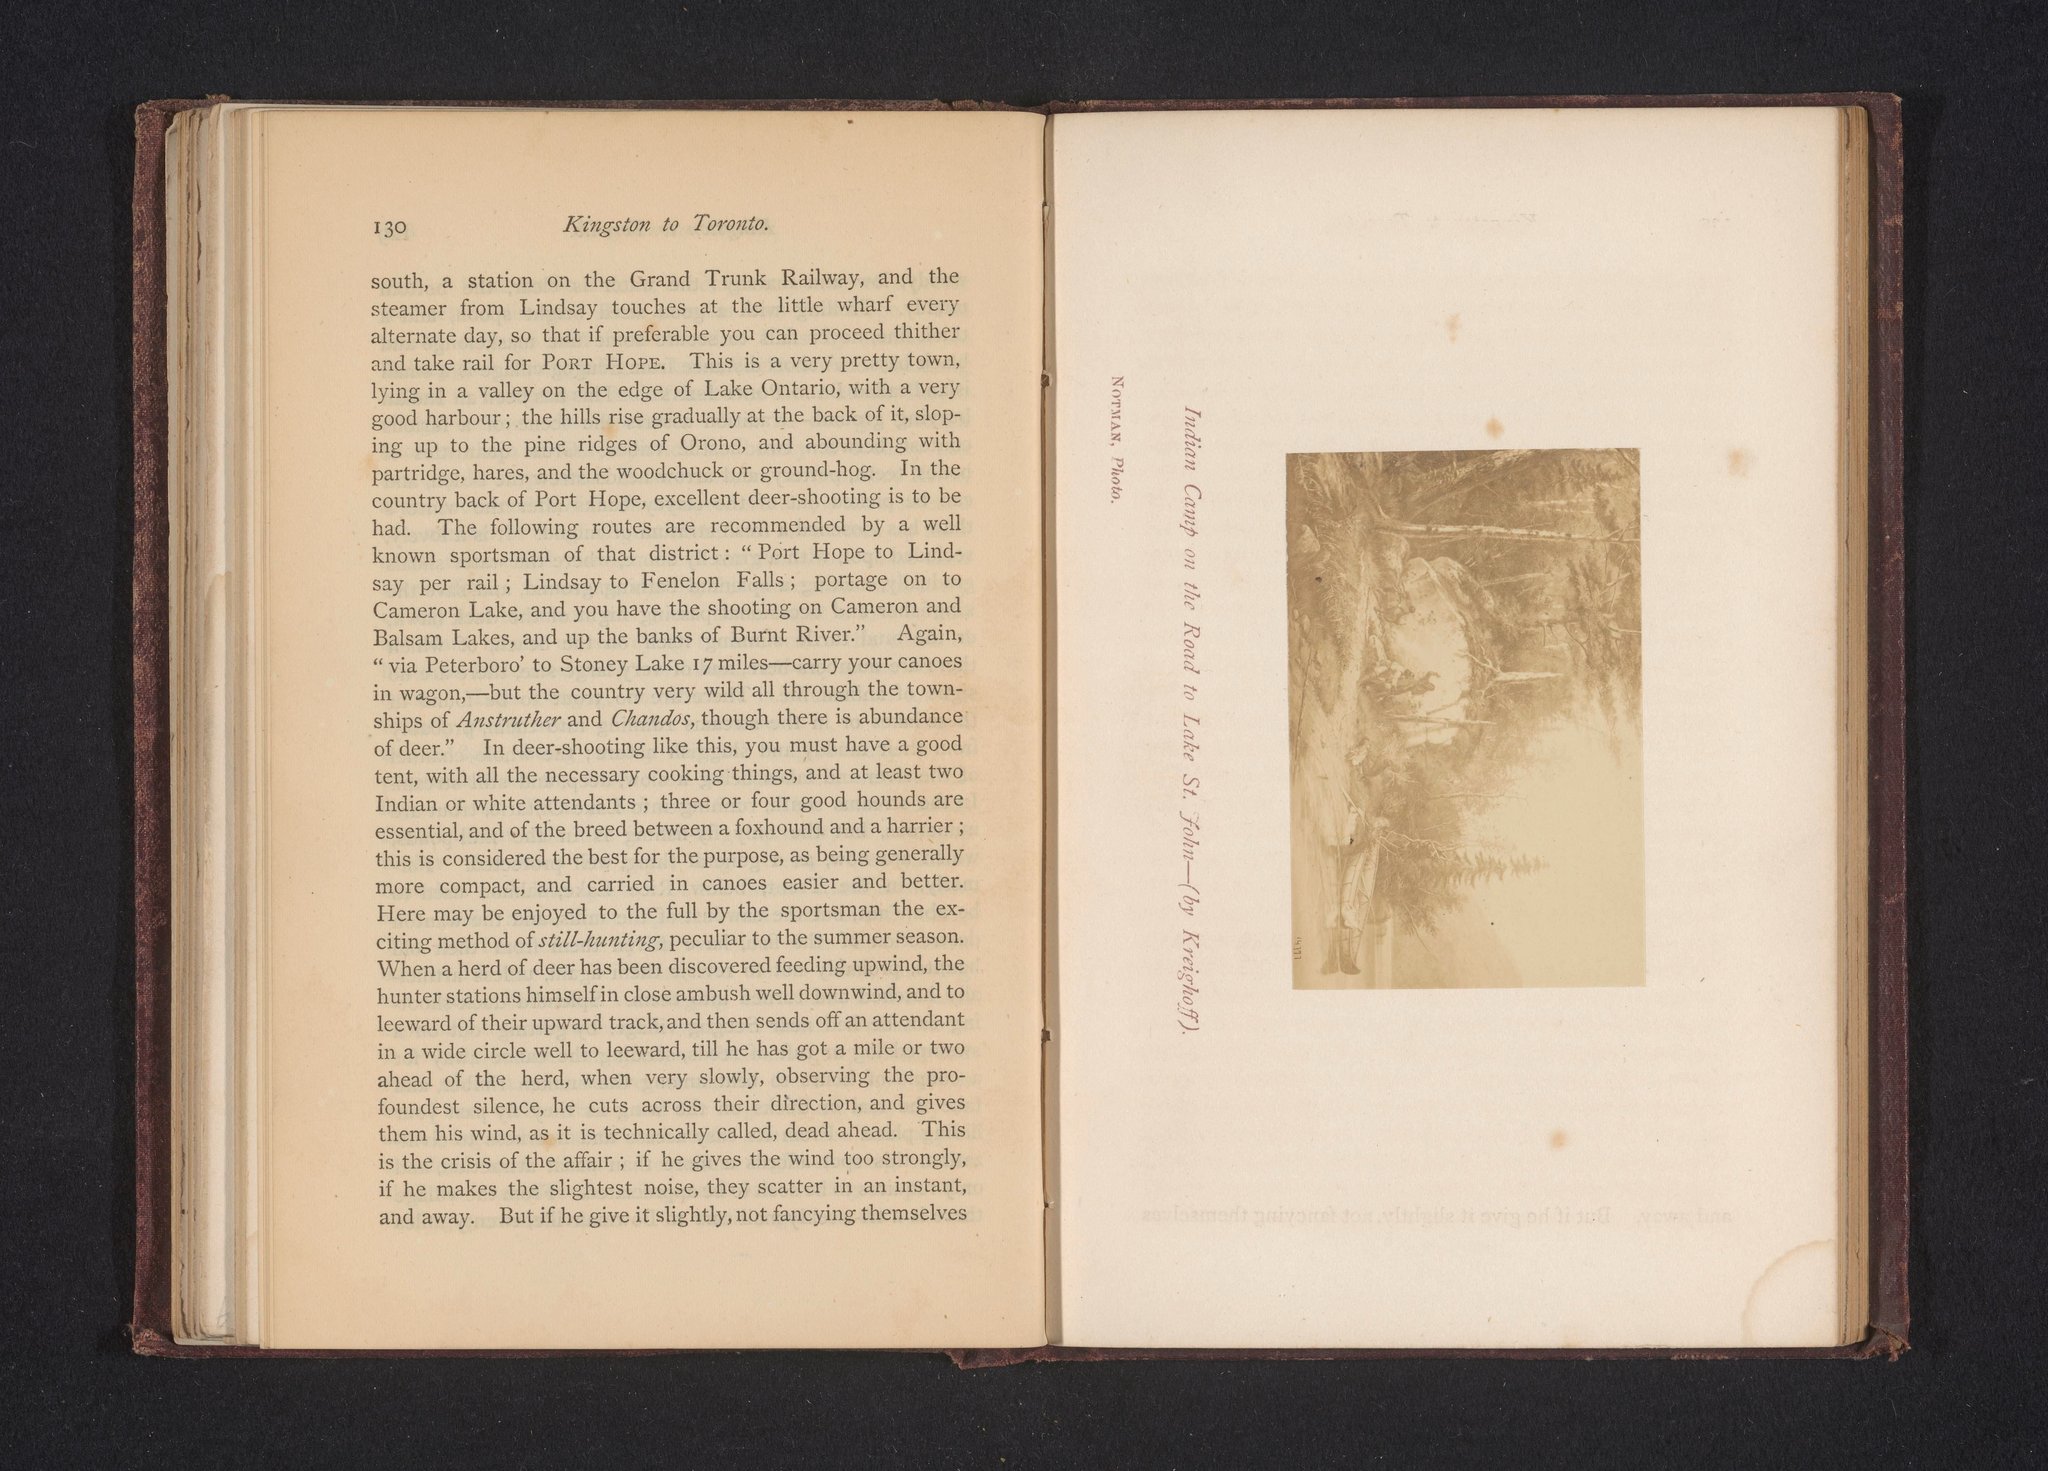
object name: page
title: Indian camp on the road to Lake St. John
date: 1856-1866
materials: photographic support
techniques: albumen print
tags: tent-camp